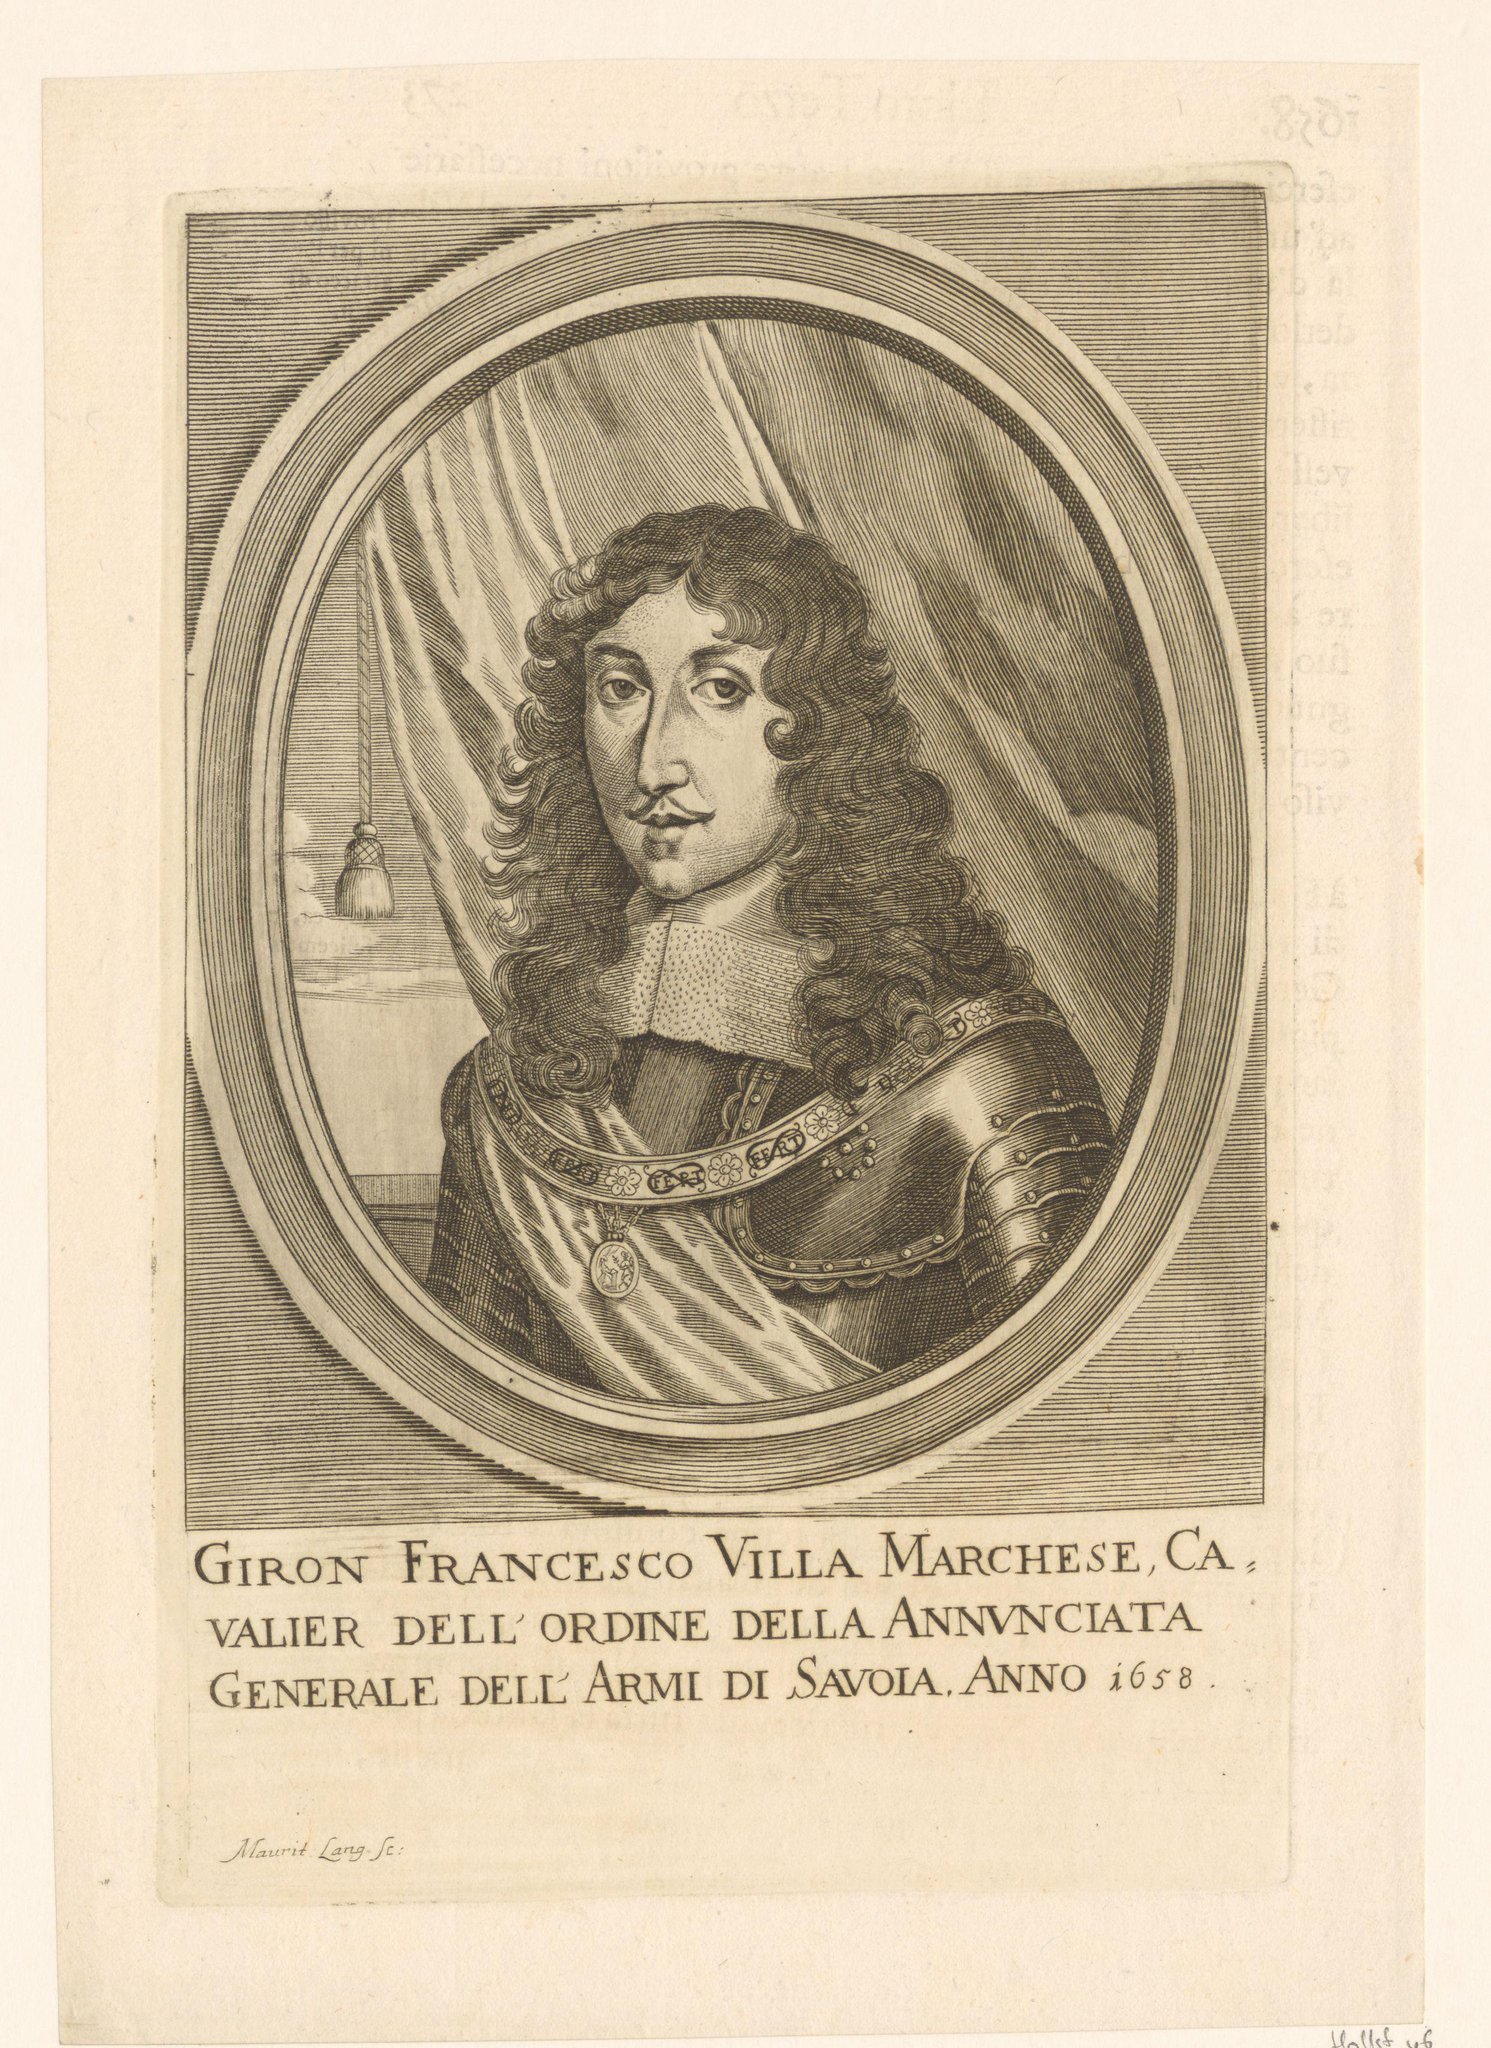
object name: print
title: Portret van Ghirone Francesco di Villa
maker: moritz lang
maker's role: draughtsman, print maker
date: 1658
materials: paper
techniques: engraving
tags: commander-in-chief, general, marshal, historical persons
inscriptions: collector's mark: Lugt 2228